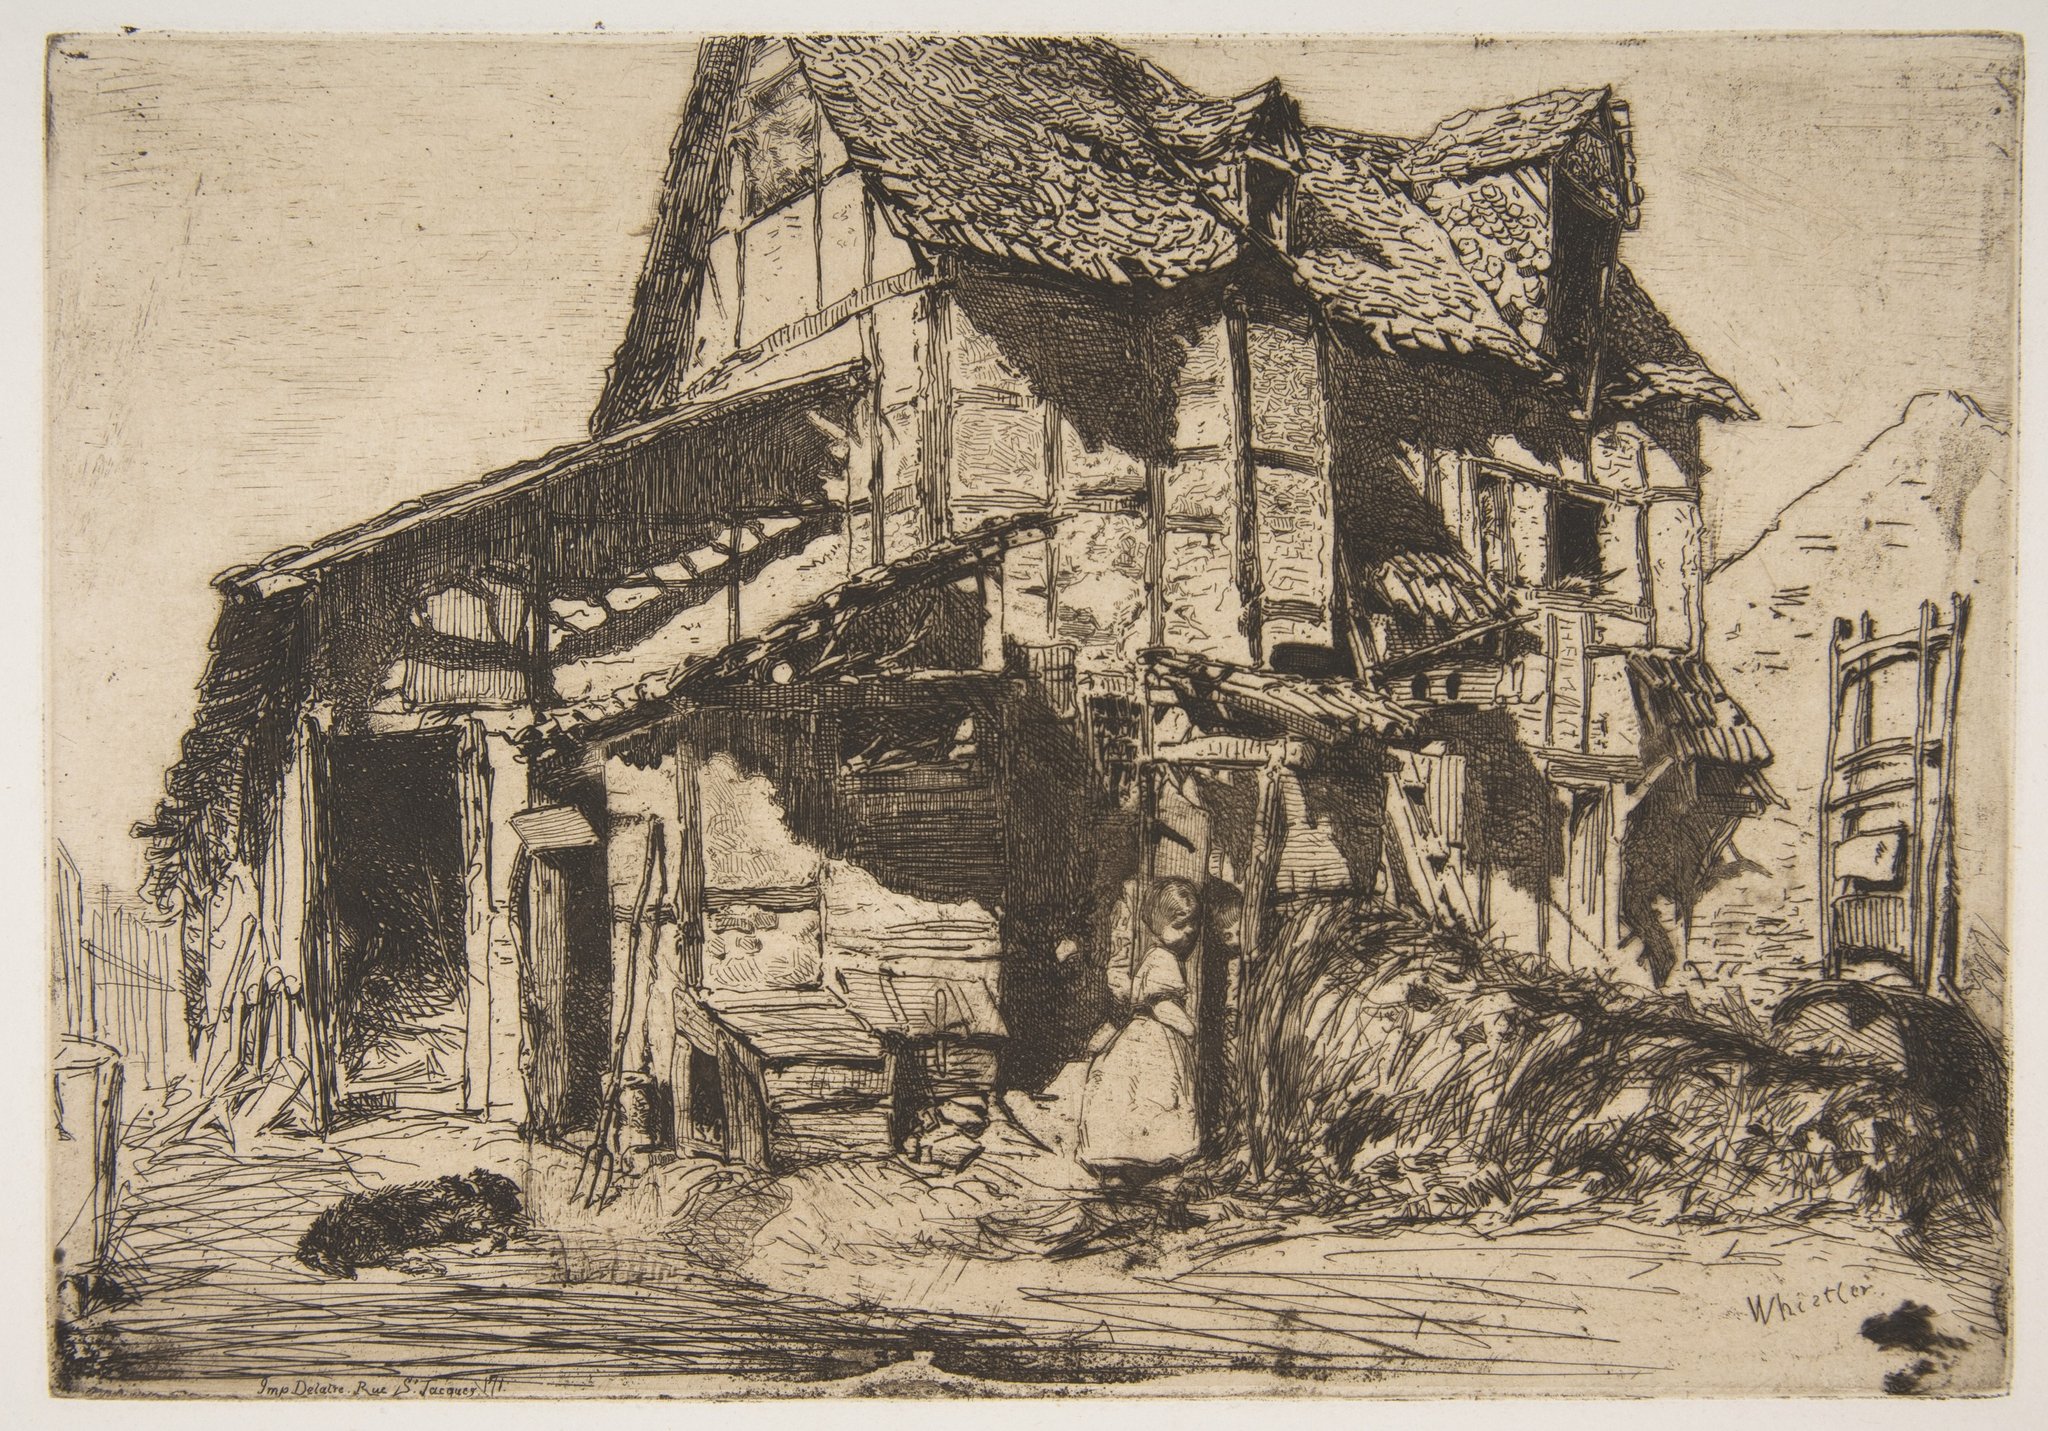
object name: print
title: The Unsafe Tenement (The Old Farm)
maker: james mcneill whistler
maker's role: artist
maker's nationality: american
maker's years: 1834-1903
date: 1858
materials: chine, ink, paper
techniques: printmaking, etching, printing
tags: houses,girls